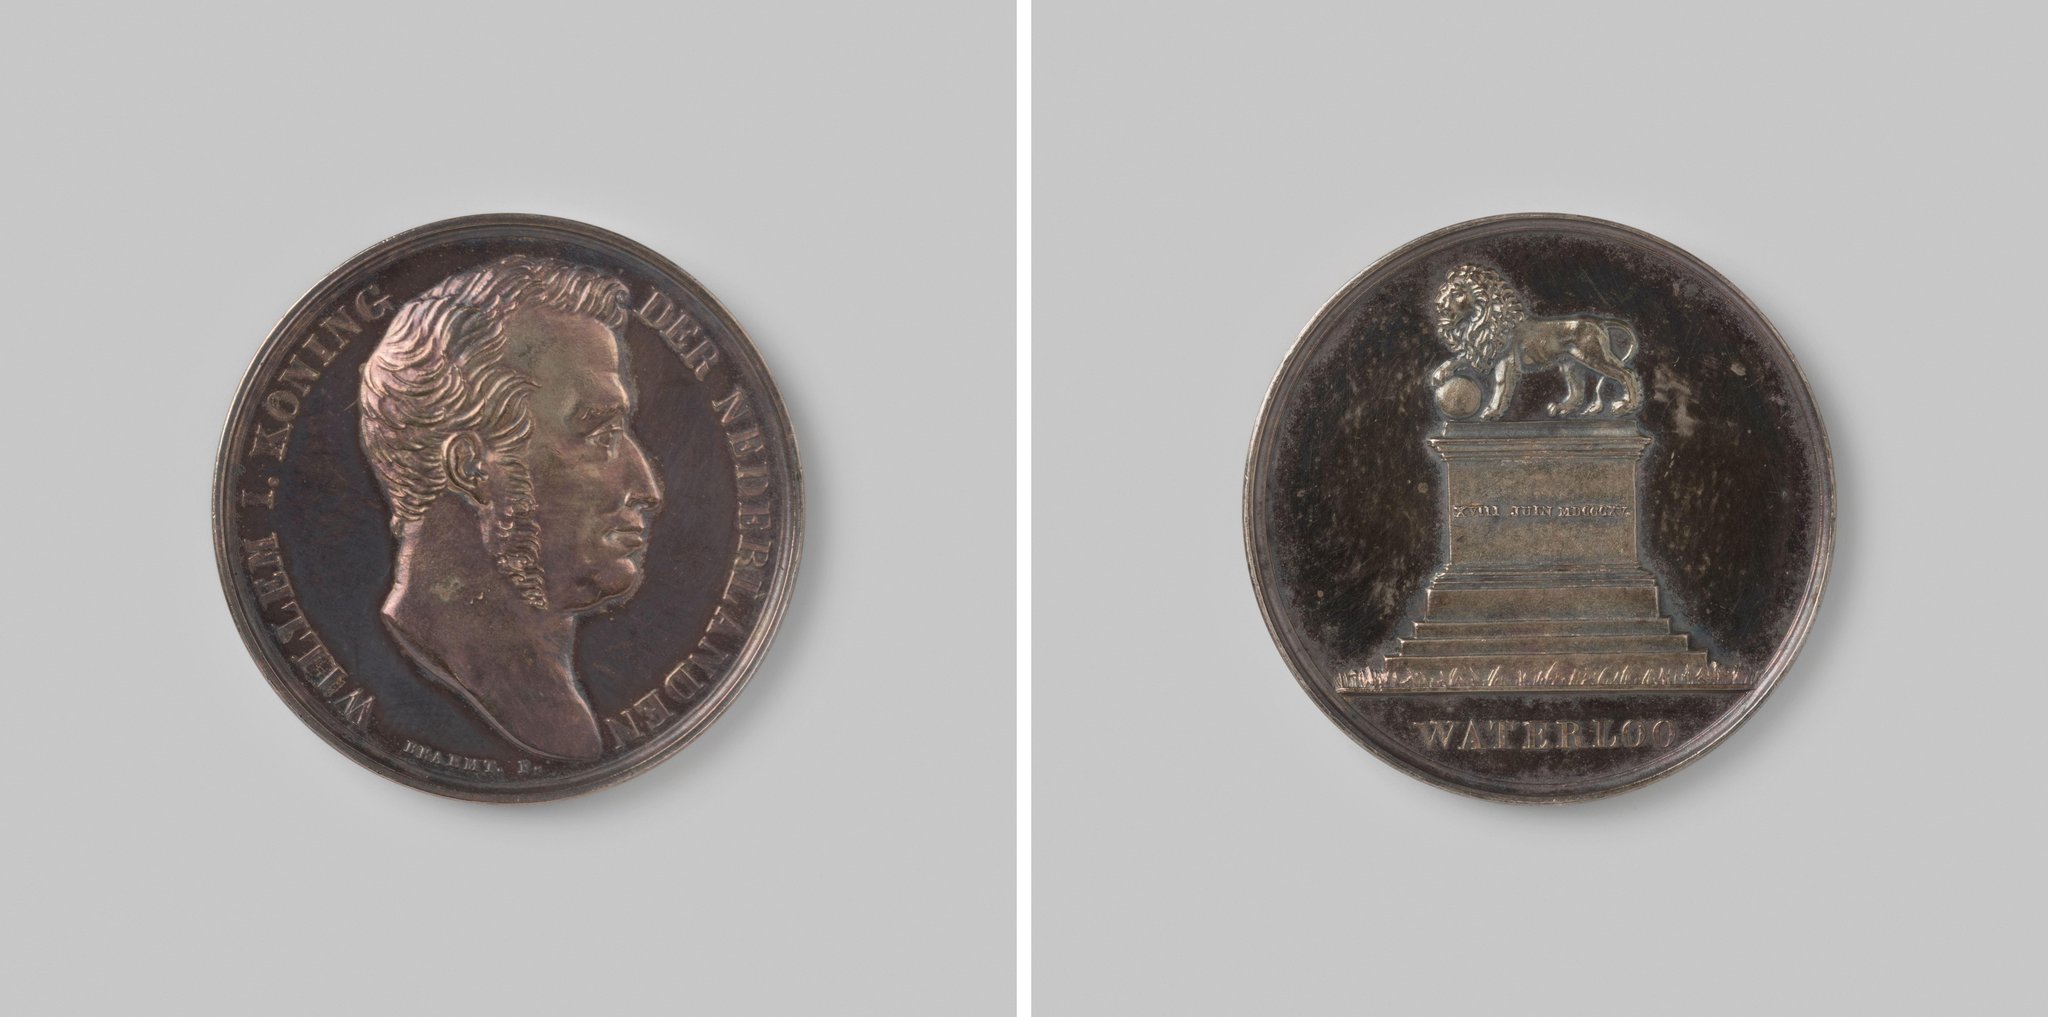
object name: history medal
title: Oprichting van het monument voor de Slag bij Waterloo 1824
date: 1824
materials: silver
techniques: striking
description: Zilveren penning, op de voorzijde het portret van Koning Willem I naar rechts met omschrift, op de keerzijde het monument van Waterloo met afsnedetekst.